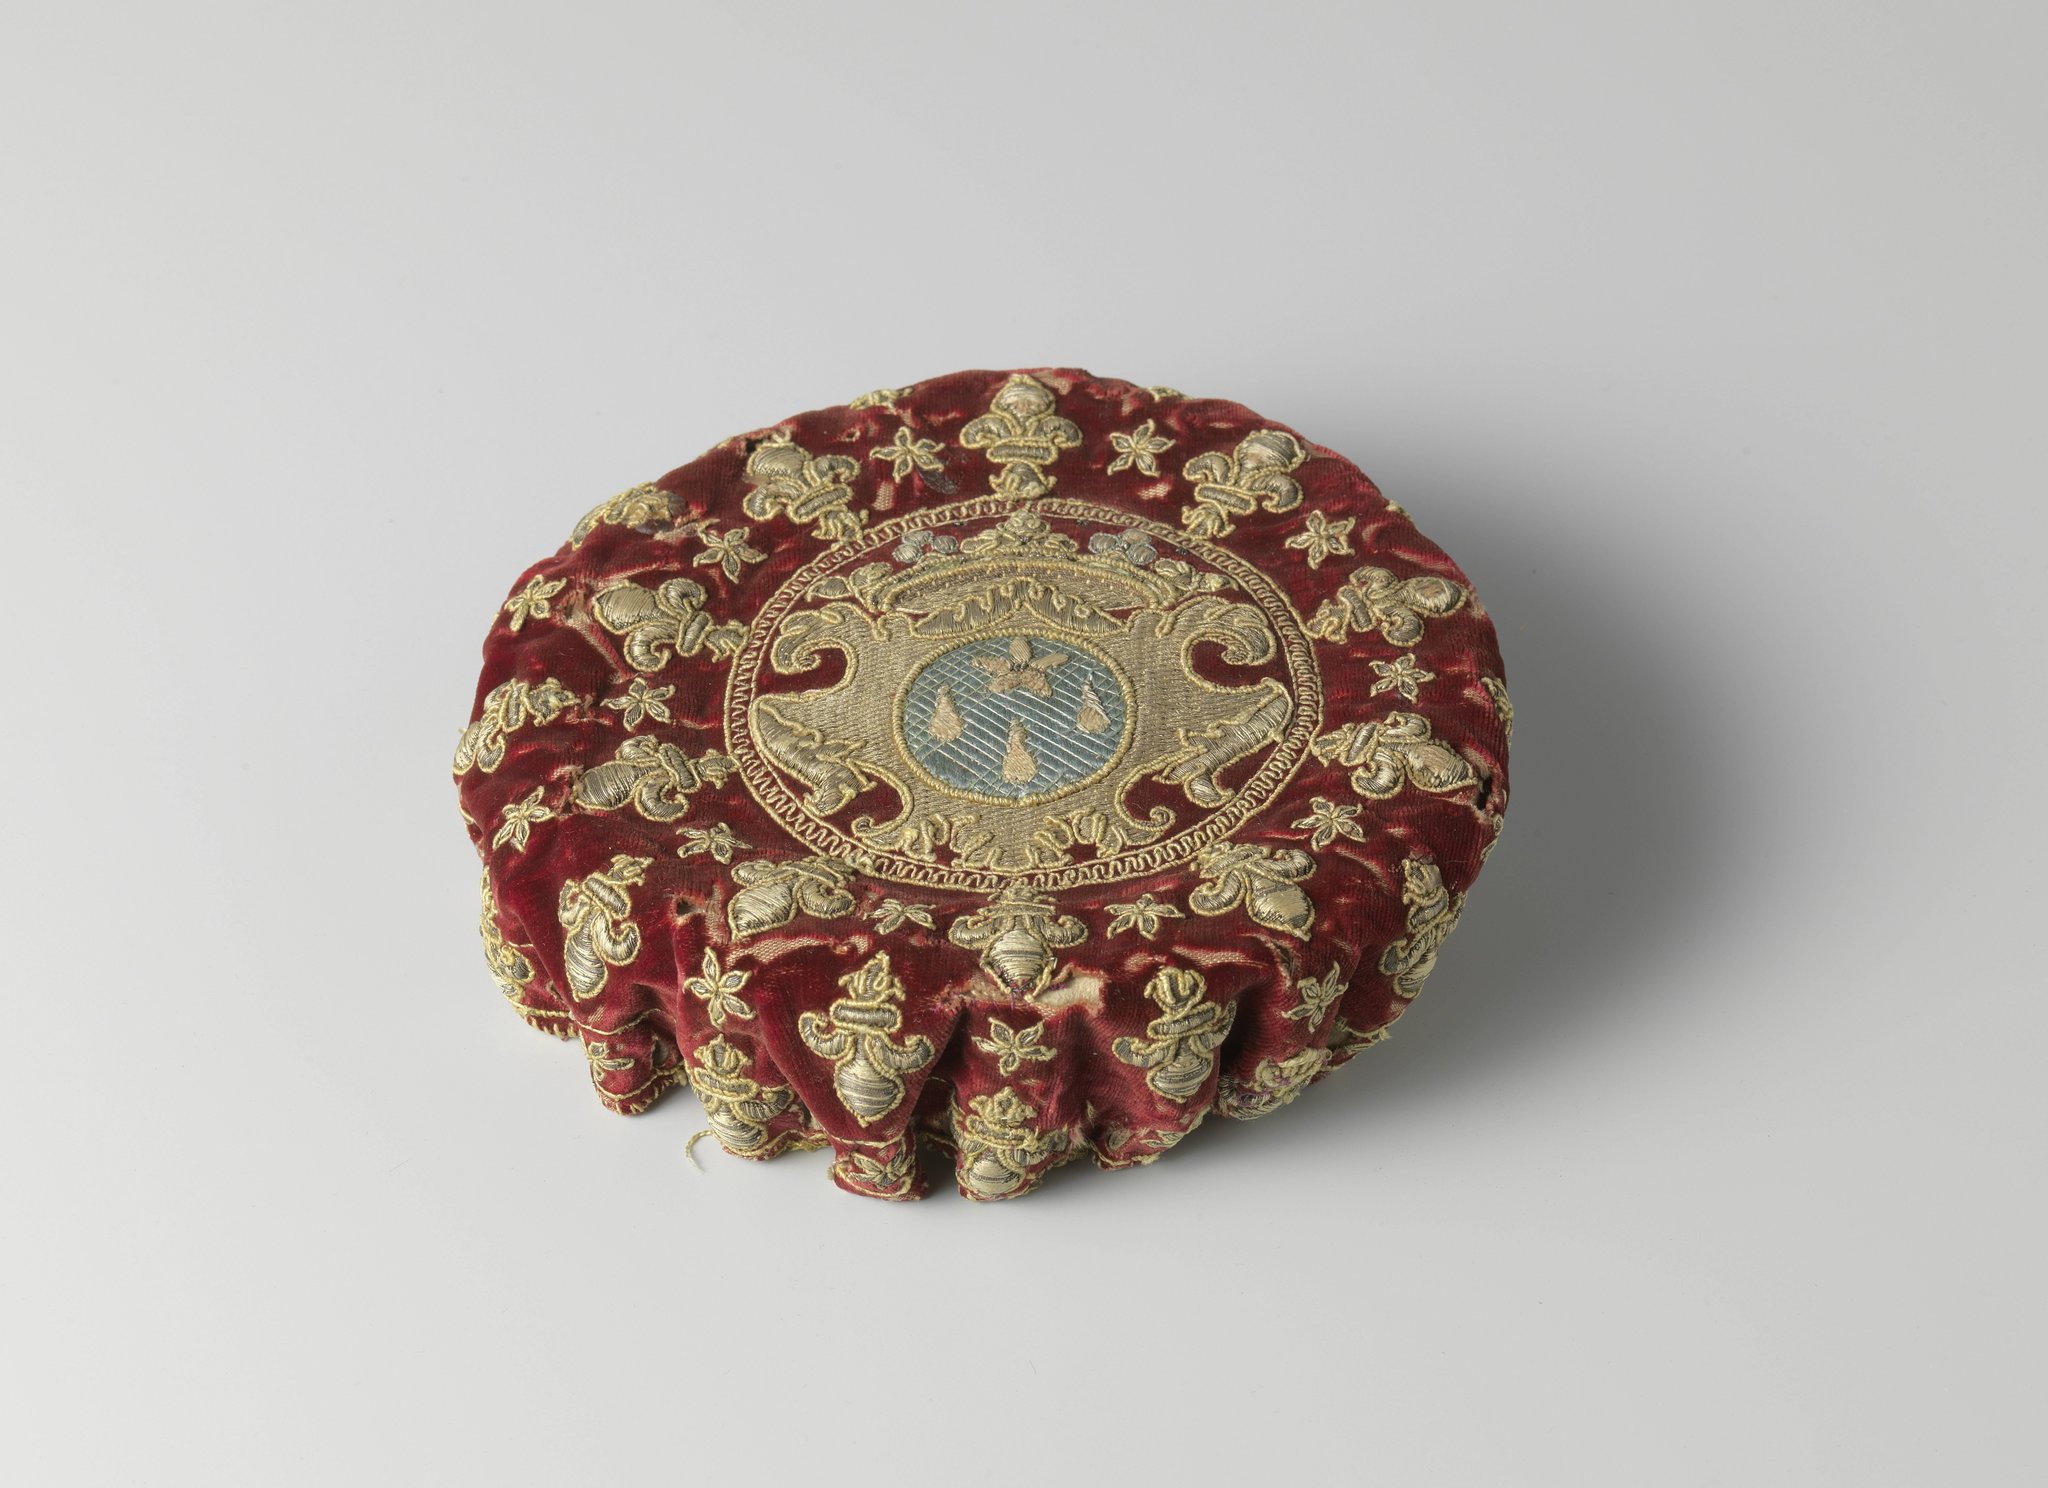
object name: speelbeurs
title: Speelbeurs van wijnrood fluweel versierd met zilverbrokaat en geborduurd in zilverdraad en veelkleurige zijde met een ongeïdentificeerd wapen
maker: Anonymous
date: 1680-1720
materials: leather, silk, thread, velvet, wood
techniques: cutting, spinning, tanning, weave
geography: france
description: Speelbeurs van wijnrood fluweel versierd met zilverbrokaat en geborduurd in zilverdraad en veelkleurige zijde met een ongeïdentificeerd wapen. Model: platte ronde bodem waar omheen een golvende opstaande rand voorzien van gaten waardoor een koord van gevlochten zijde - eindigend in een knop met houten kern en omwonden met zijde - is getrokken. Gevoerd met geitenleer, waar oorspronkelijk rode zijde overheen zat; nu slechts resten hiervan over. Versiering: de 20 uitstulpingen of 'ribben' zijn versierd met een strooimotief van Franse lelies en bloemen of sterren in reliëf van zilverdraad. Op driekwart hoogte loopt een horizontale lijn van zilverdraad. Langs de bovenkant was oorspronkelijk een passement van zilverdraad met festonsteken vastgezet. Van het passement zijn slechts een paar resten overgebleven. De bodem is omcirkeld met een dubbele rand waarbinnen een zigzaglijn van zilverdraad. Hierin een fleuron van zilverbrokaat waarop een ovaal schild met een geborduurd fond van blauwe zijde waarin drie druppelvormige ornamenten onder een bloem of ster. Boven de fleuron een kroon in reliëf.